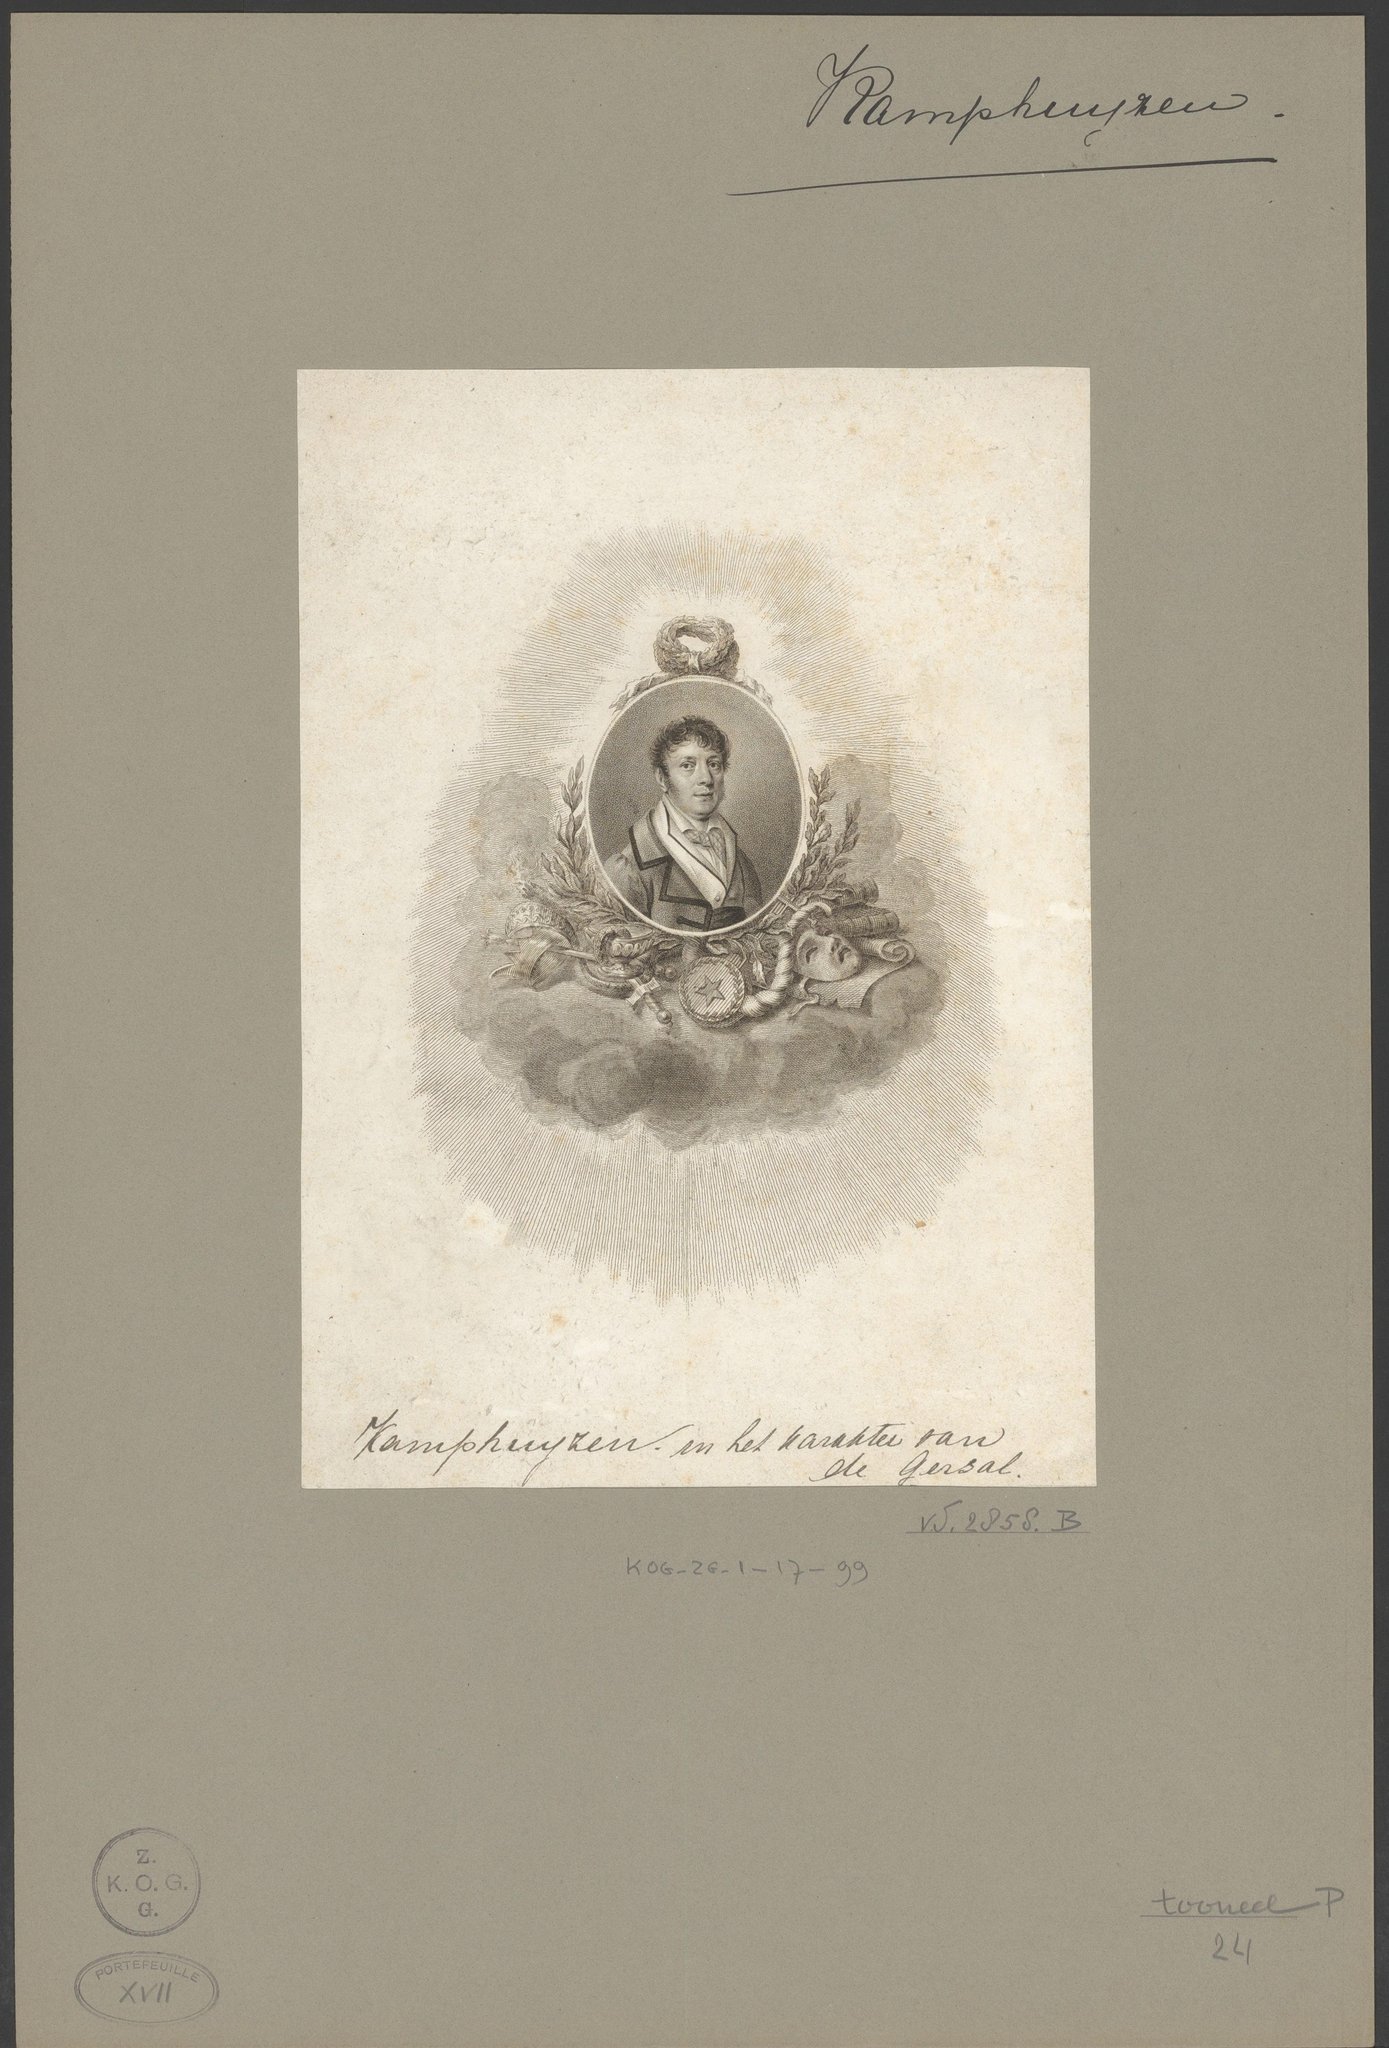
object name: print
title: Portret van Dirk Kamphuijzen in de rol van Gersal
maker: jan willem caspari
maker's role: print maker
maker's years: 1779-1822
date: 1794-1822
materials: paper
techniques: etching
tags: theatre, theatrical performance, historical persons, the arts of the stage: ballet, theatre, musical drama, motion picture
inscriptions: collector's mark: Lugt 1641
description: Onderwerpsrubrieken binnen de Atlas Zeden en Gewoonten: Tooneel, Portretten van toneelspelers.